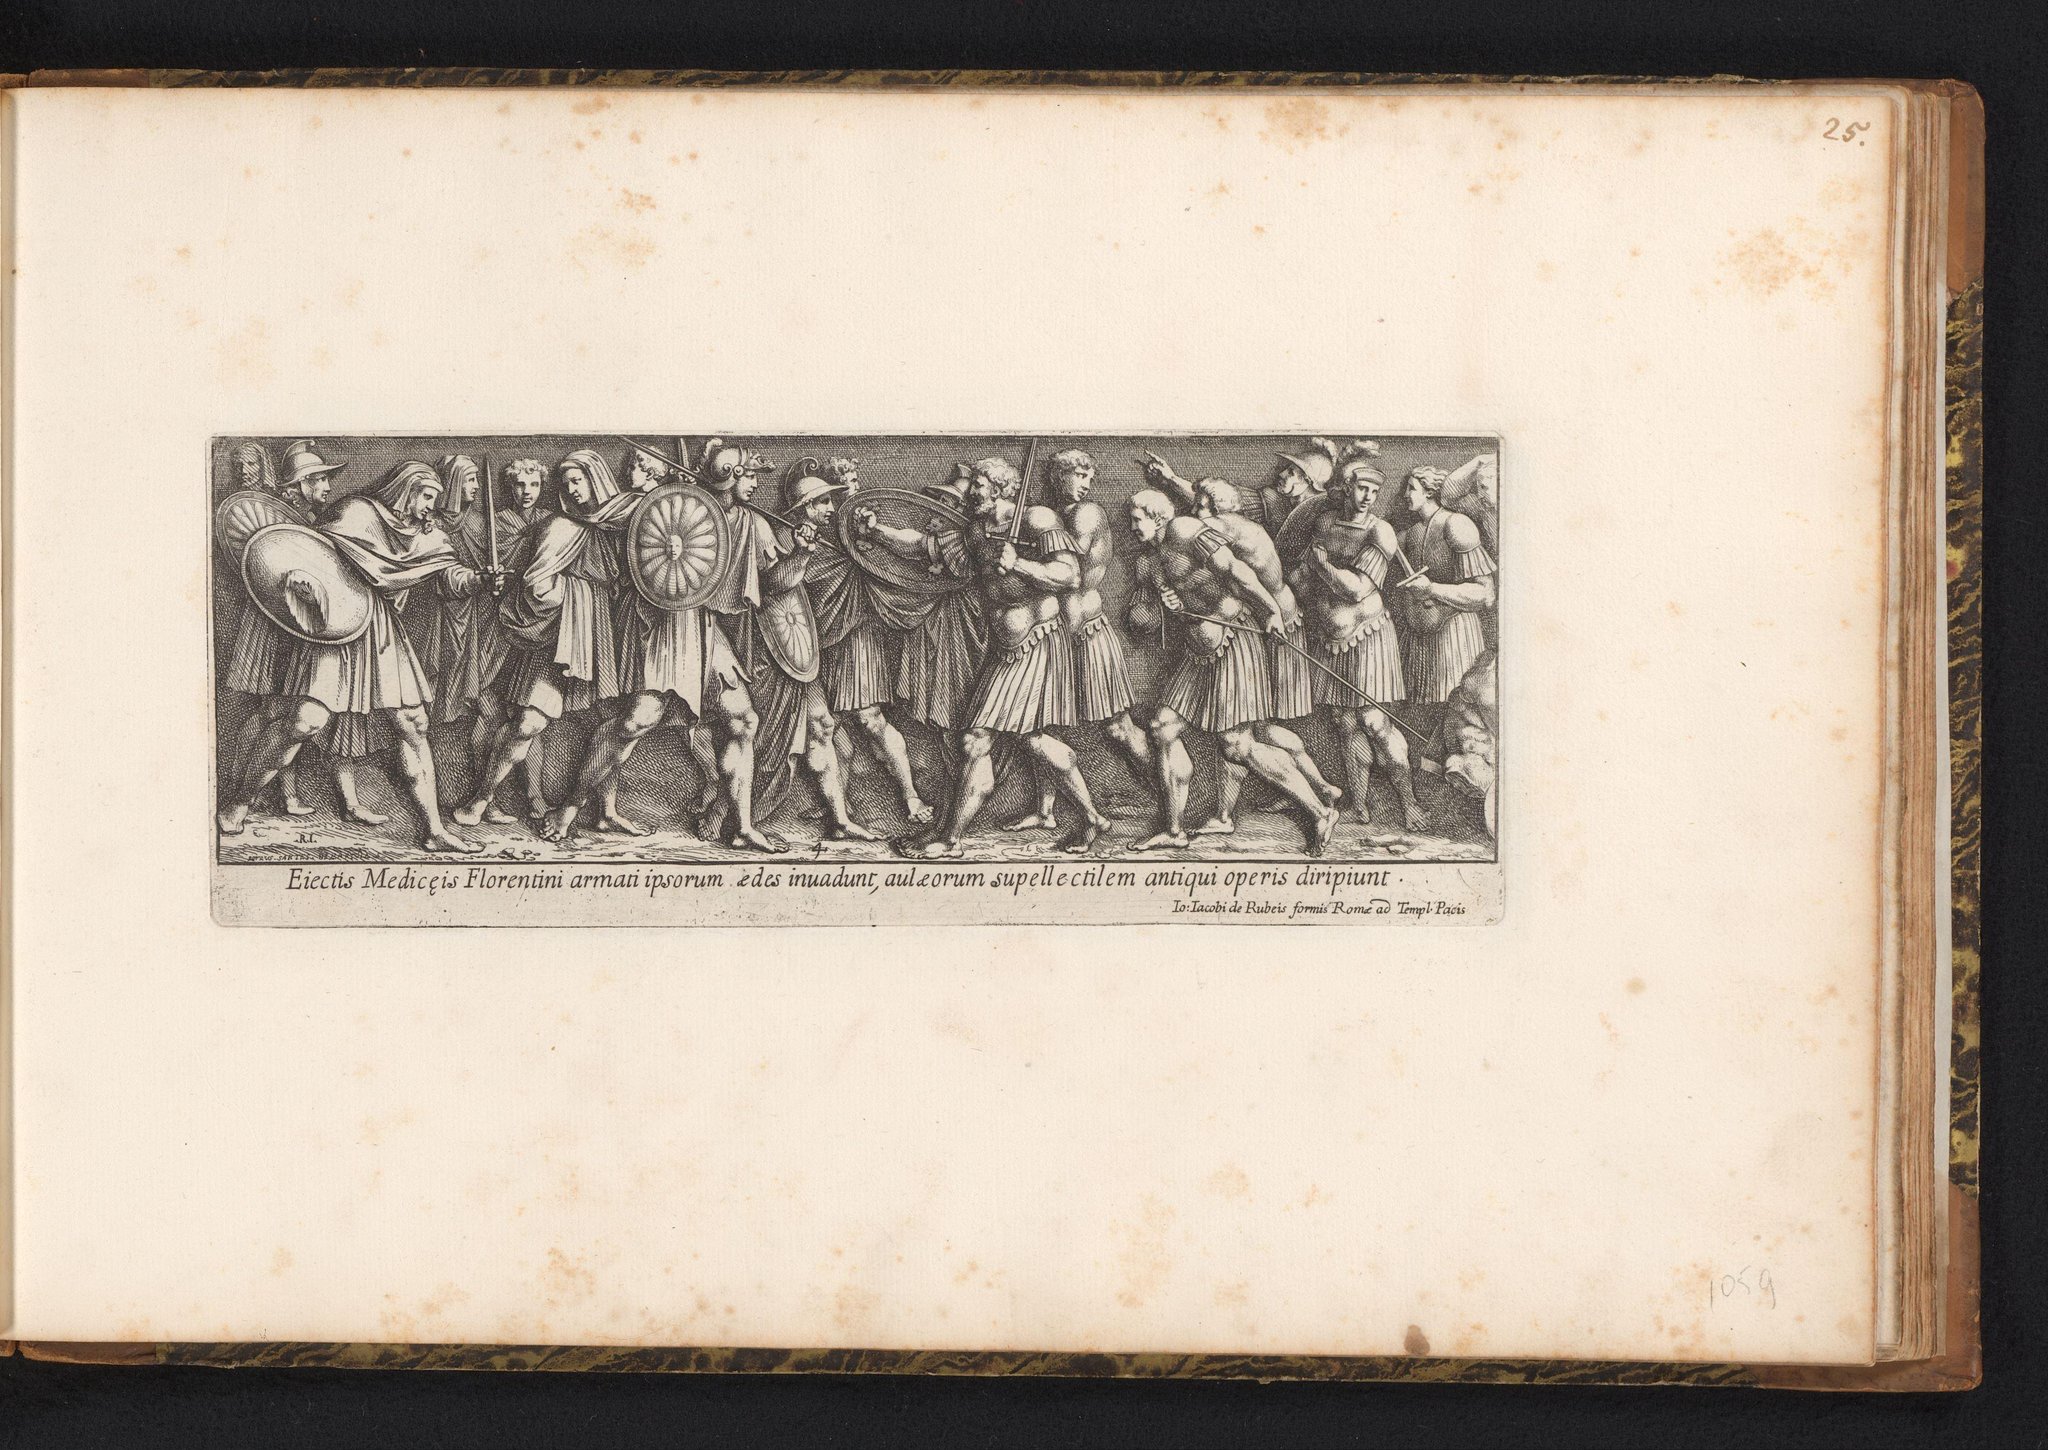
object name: album leaf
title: Eiectis Mediceis Florentini armati ipsorum edes invadunt, auleorum supellectilem antiqui operis diripiunt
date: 1645-1700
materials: paper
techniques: engraving, etching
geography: vatican city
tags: battle, the soldier; the soldier's life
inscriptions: number: ‘25’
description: Soldaten in gevecht, omdat de Medici familie verbannen is uit Florence. Titel in ondermarge. Genummerd midden onder: 4. Prent maakt deel uit van een album.